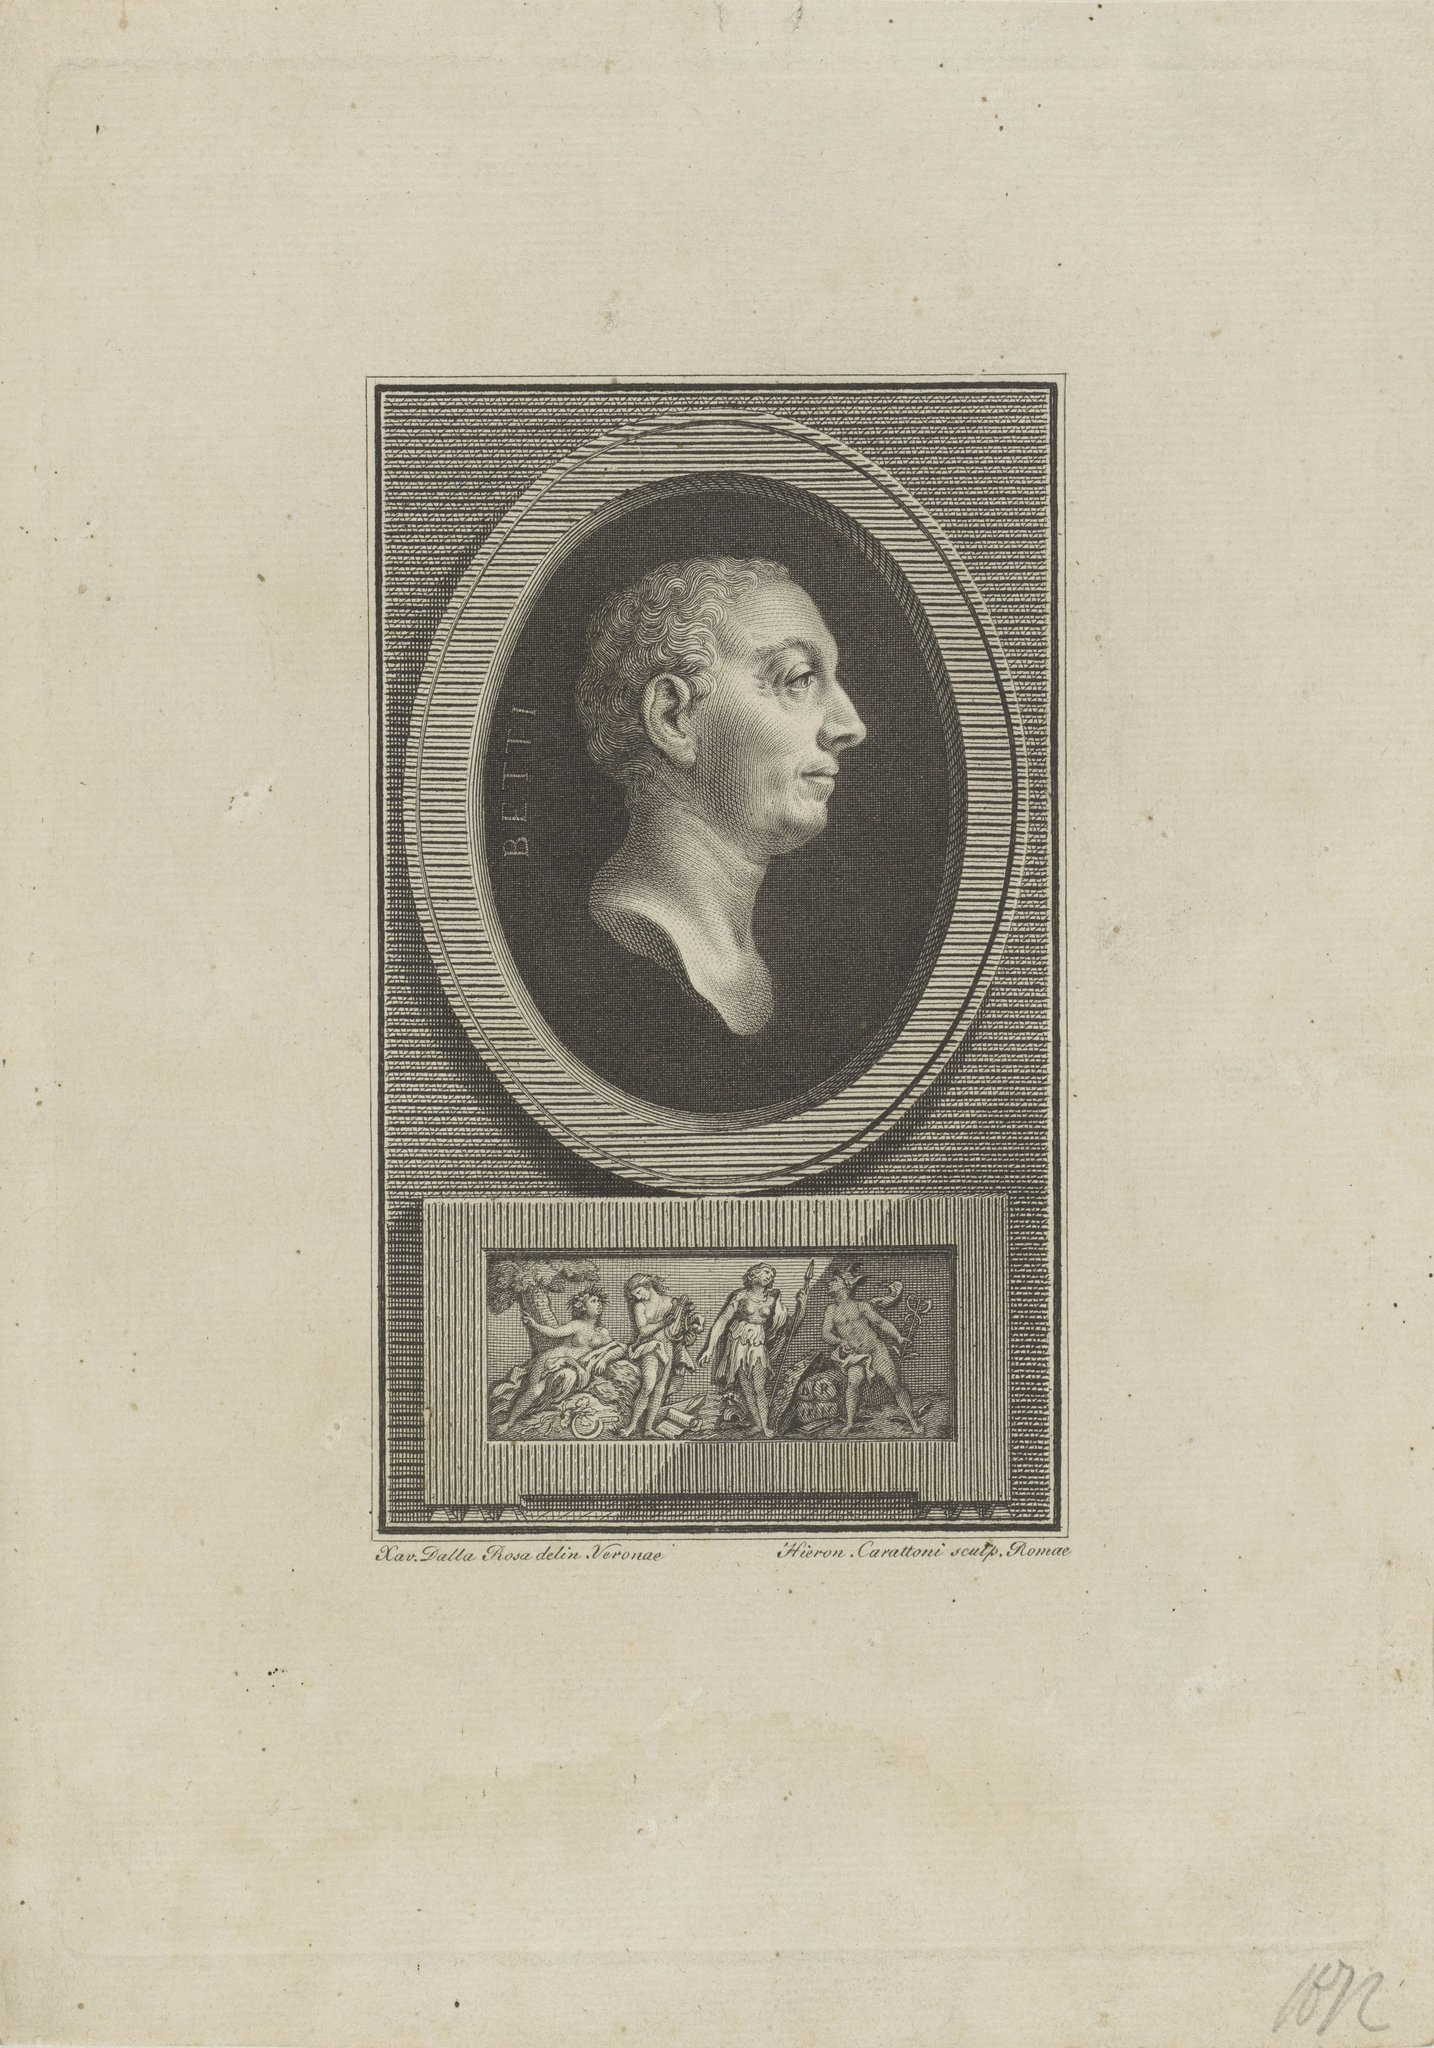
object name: print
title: Portret van musicus Betti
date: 1767-1809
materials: paper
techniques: engraving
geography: verona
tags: musician, historical persons, portrait of a musician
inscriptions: collector's mark: Lugt 2228